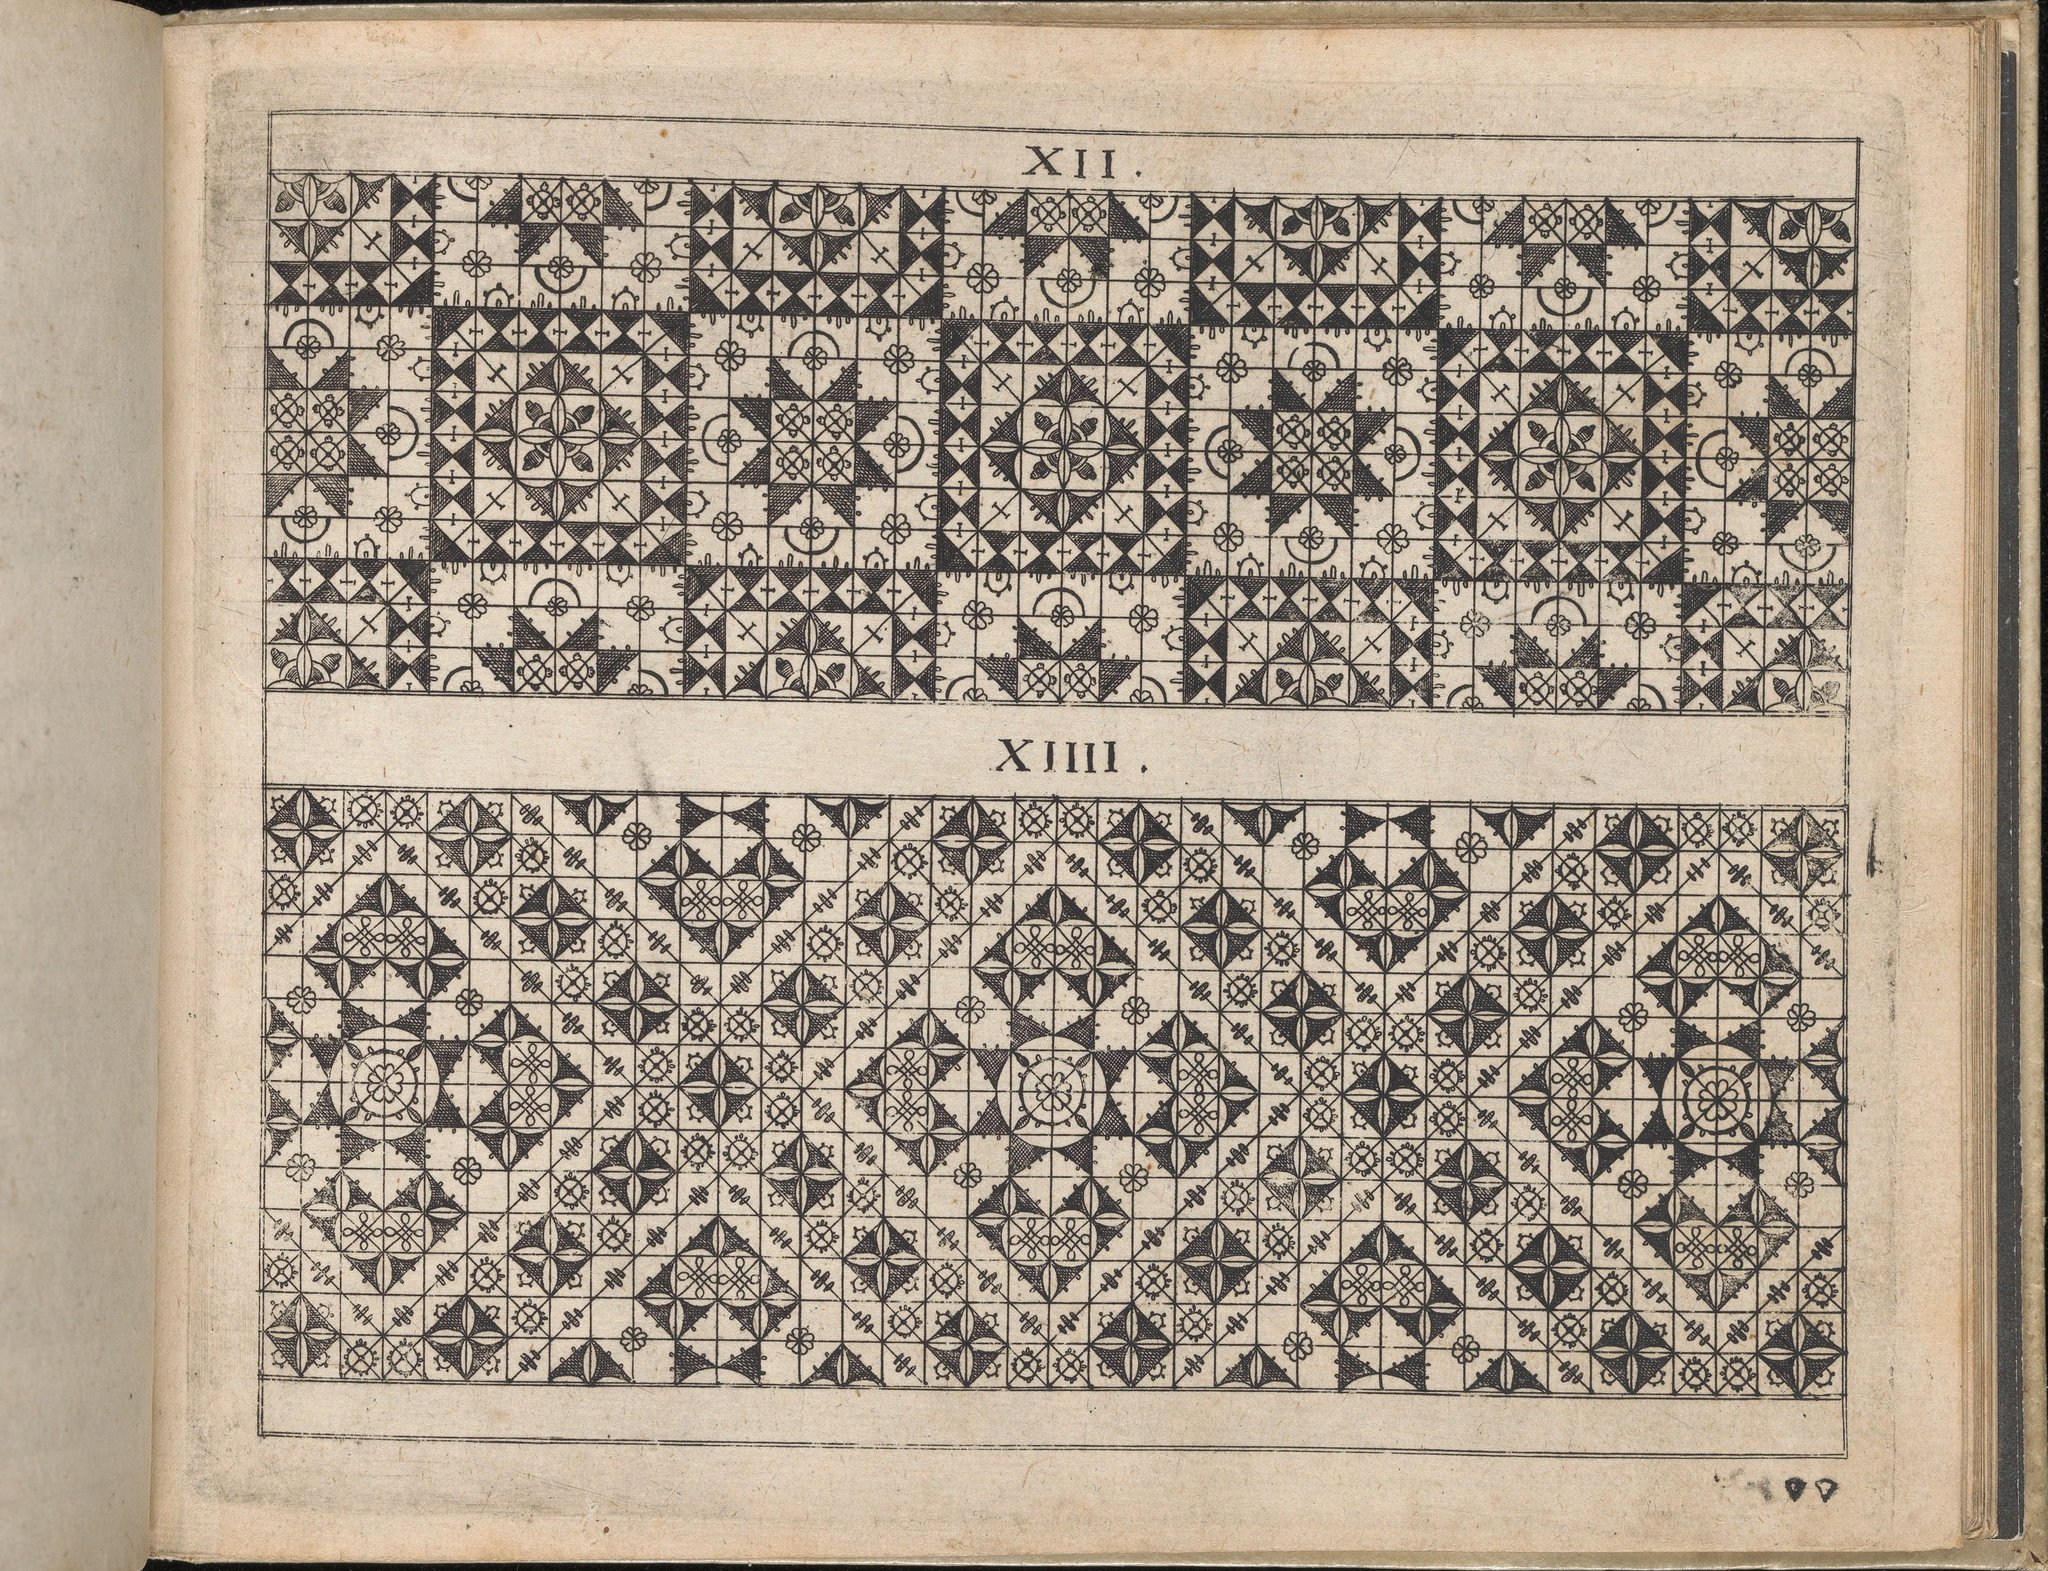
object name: book print ornament architecture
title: Newes Modelbuch in Kupffer (Page 48r)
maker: johann sibmacher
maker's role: artist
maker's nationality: german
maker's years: 1590-1611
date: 1604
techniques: etching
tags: ornament